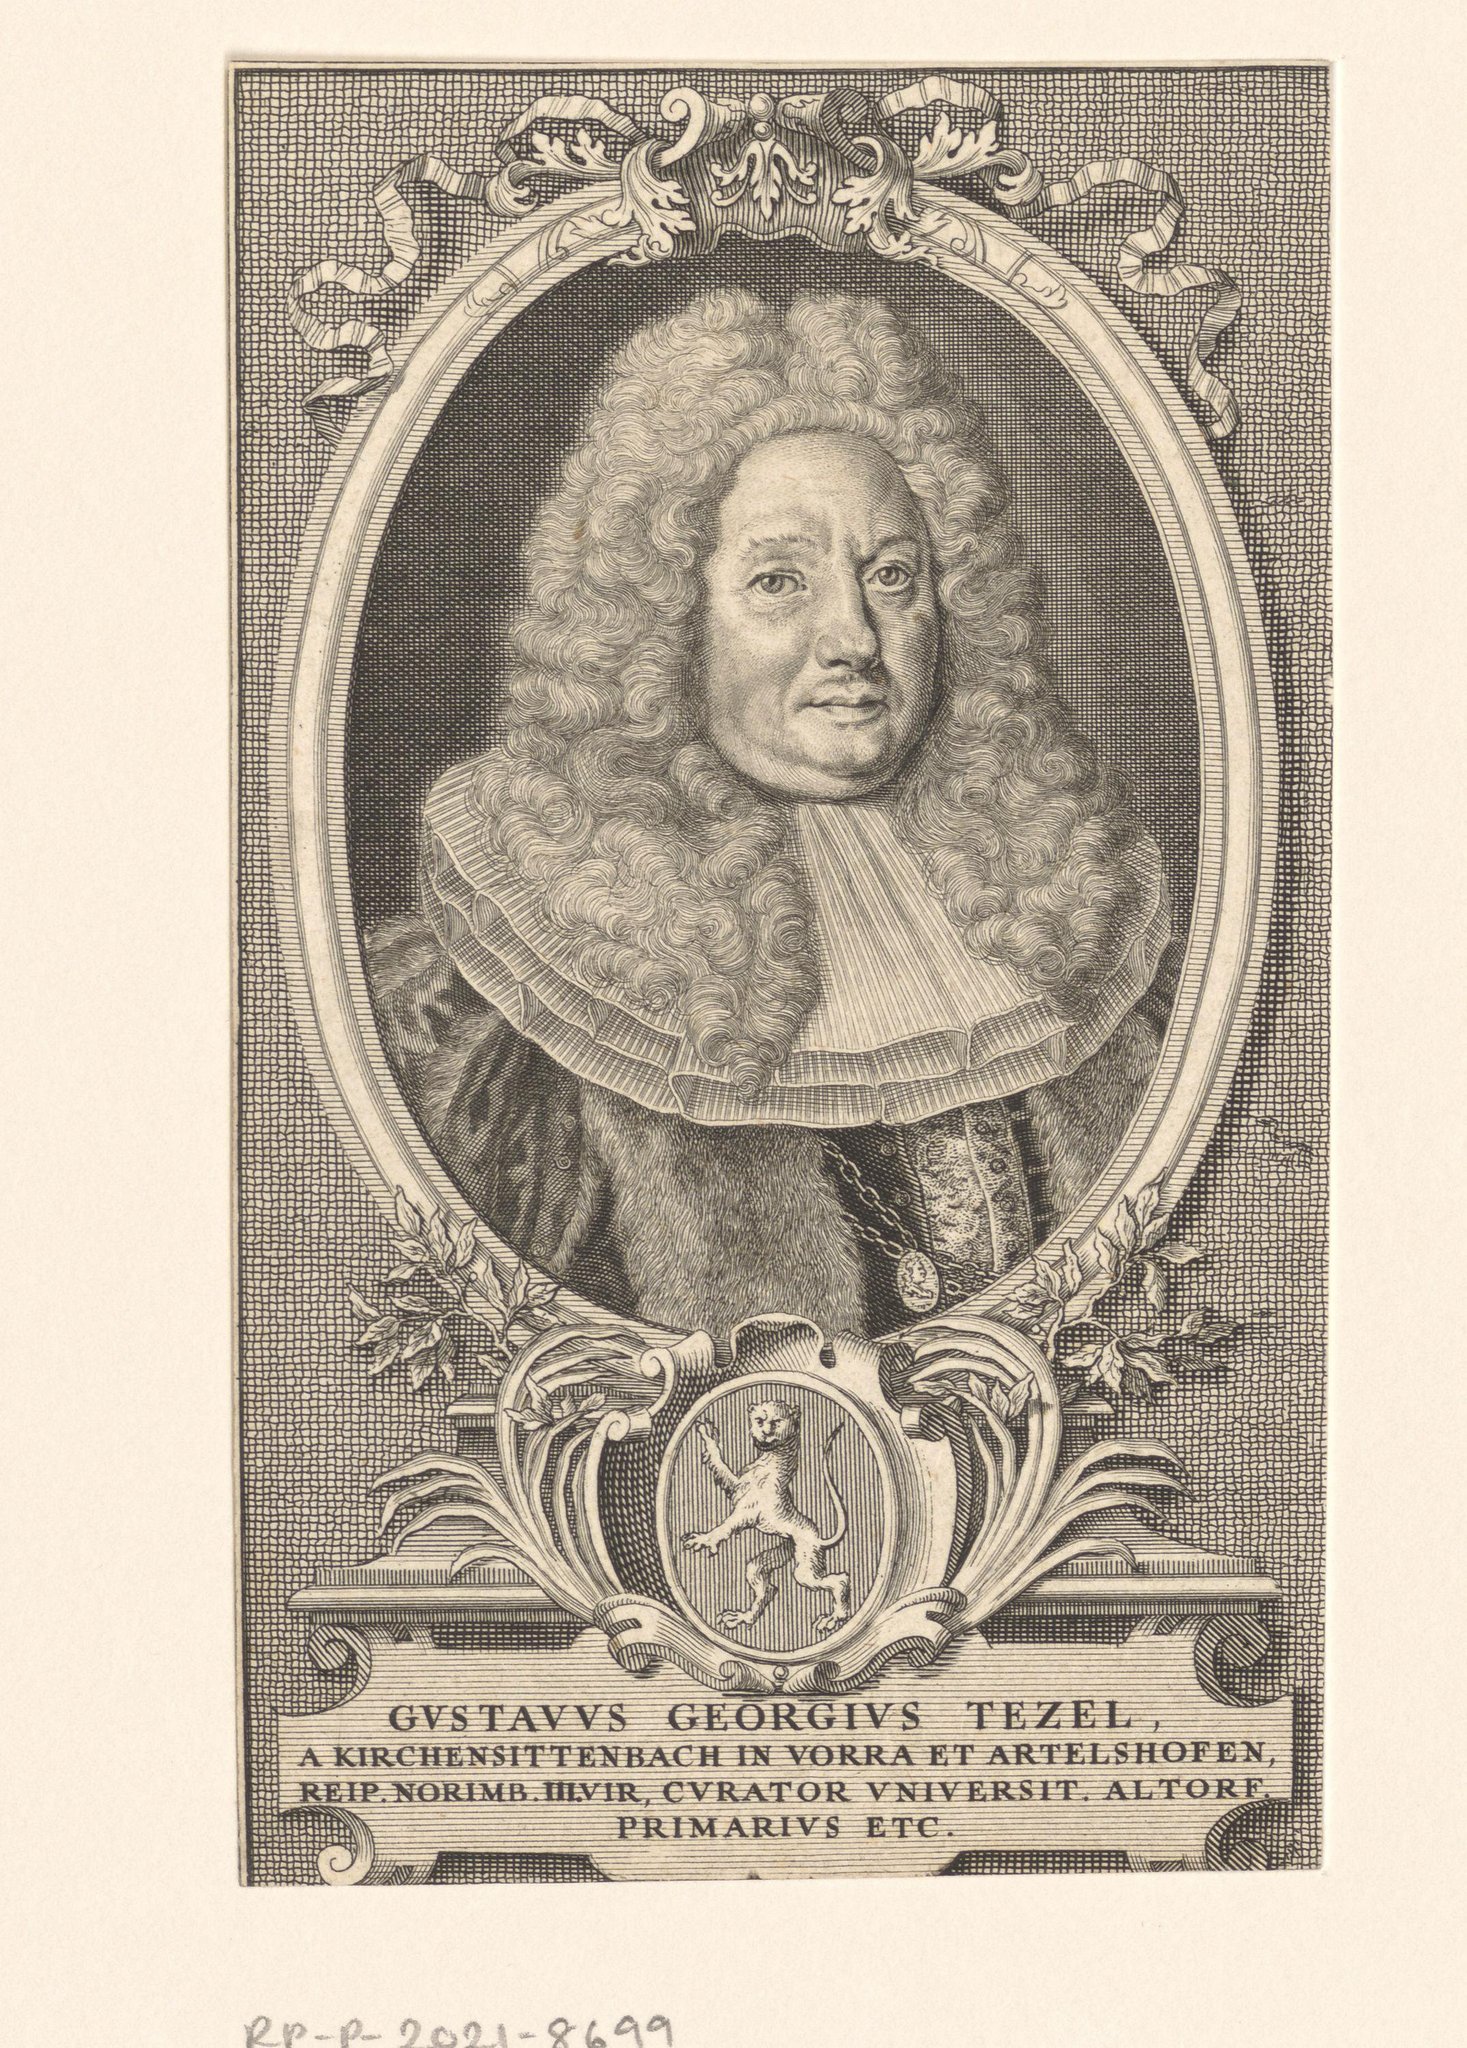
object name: print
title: Portret van Gustav Georg Tetzel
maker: Anonymous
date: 1700-1749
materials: paper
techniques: engraving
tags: mayor, mayor, burgomaster, historical persons, armorial bearing, heraldry